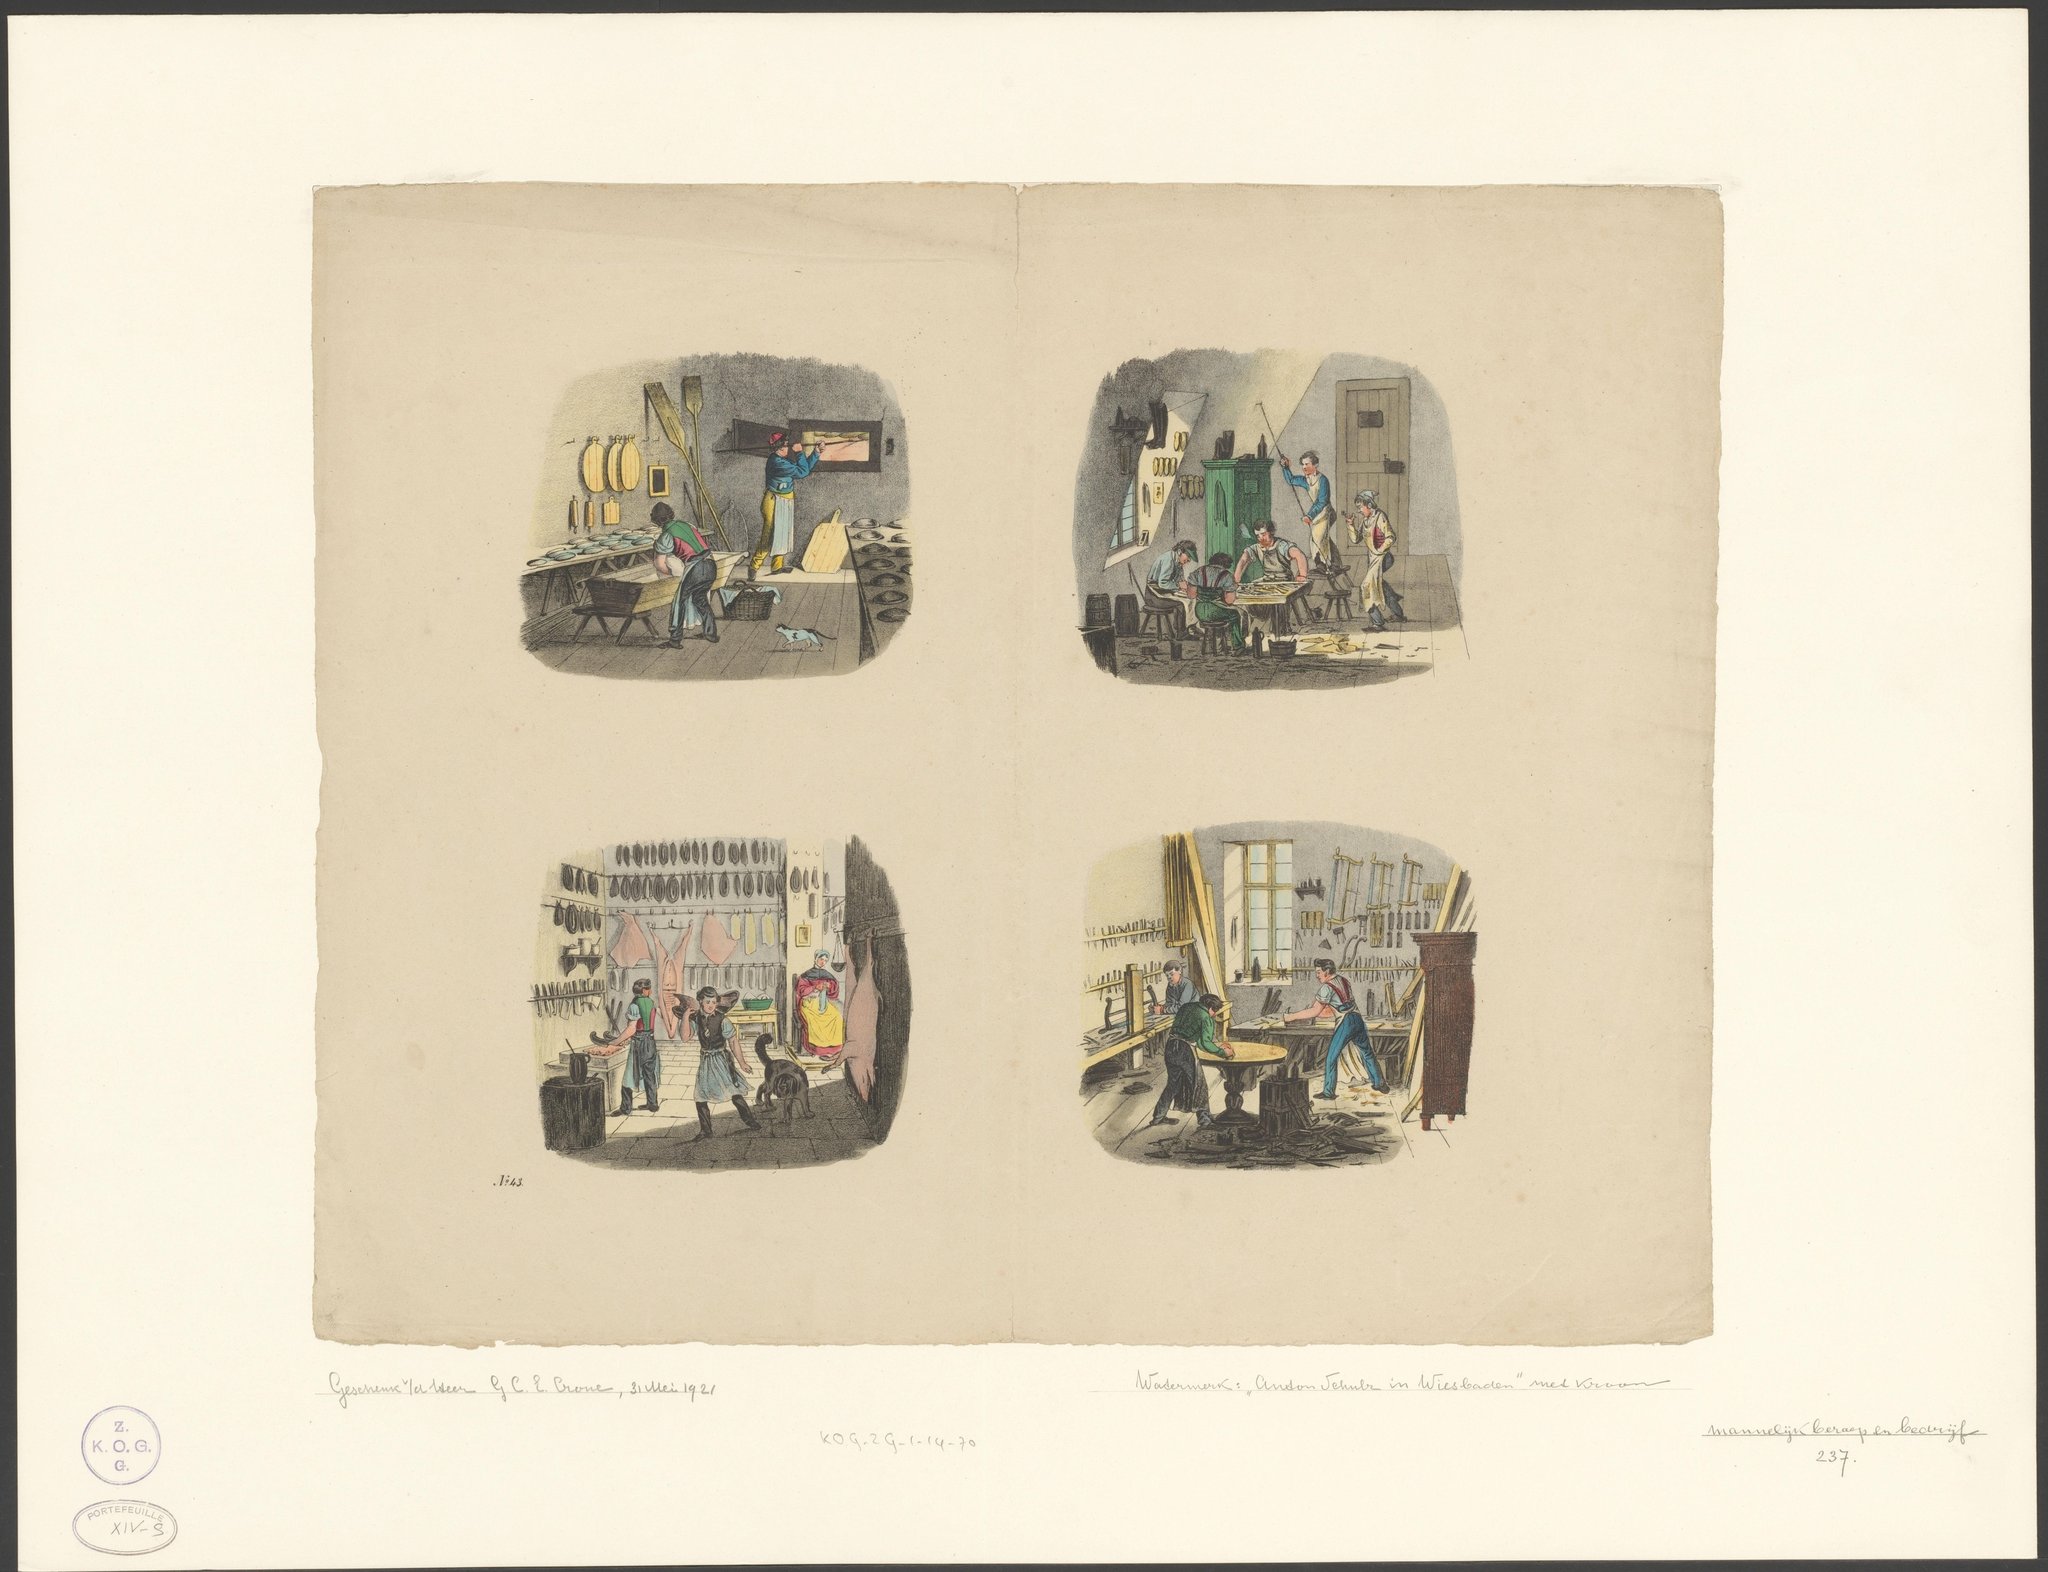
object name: print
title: Blad met vier ambachten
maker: Anonymous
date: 1850-1899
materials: paper, watercolor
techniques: lithograph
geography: germany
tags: joiner, cabinet maker, 'ébéniste', baker, butcher, slaughterman, crafts and industries, shoe-maker, cobbler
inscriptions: collector's mark: Lugt 1641, collector's mark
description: Blad met vier ambachten: bakker, varkensslager, schoenmaker en schrijnwerker. Linksonder genummerd: No. 43. Onderwerpsrubrieken binnen de Atlas Zeden en Gewoonten: Mannelijk beroep en bedrijf: Varia en kinderprenten betrekkelijk het onderwerp.